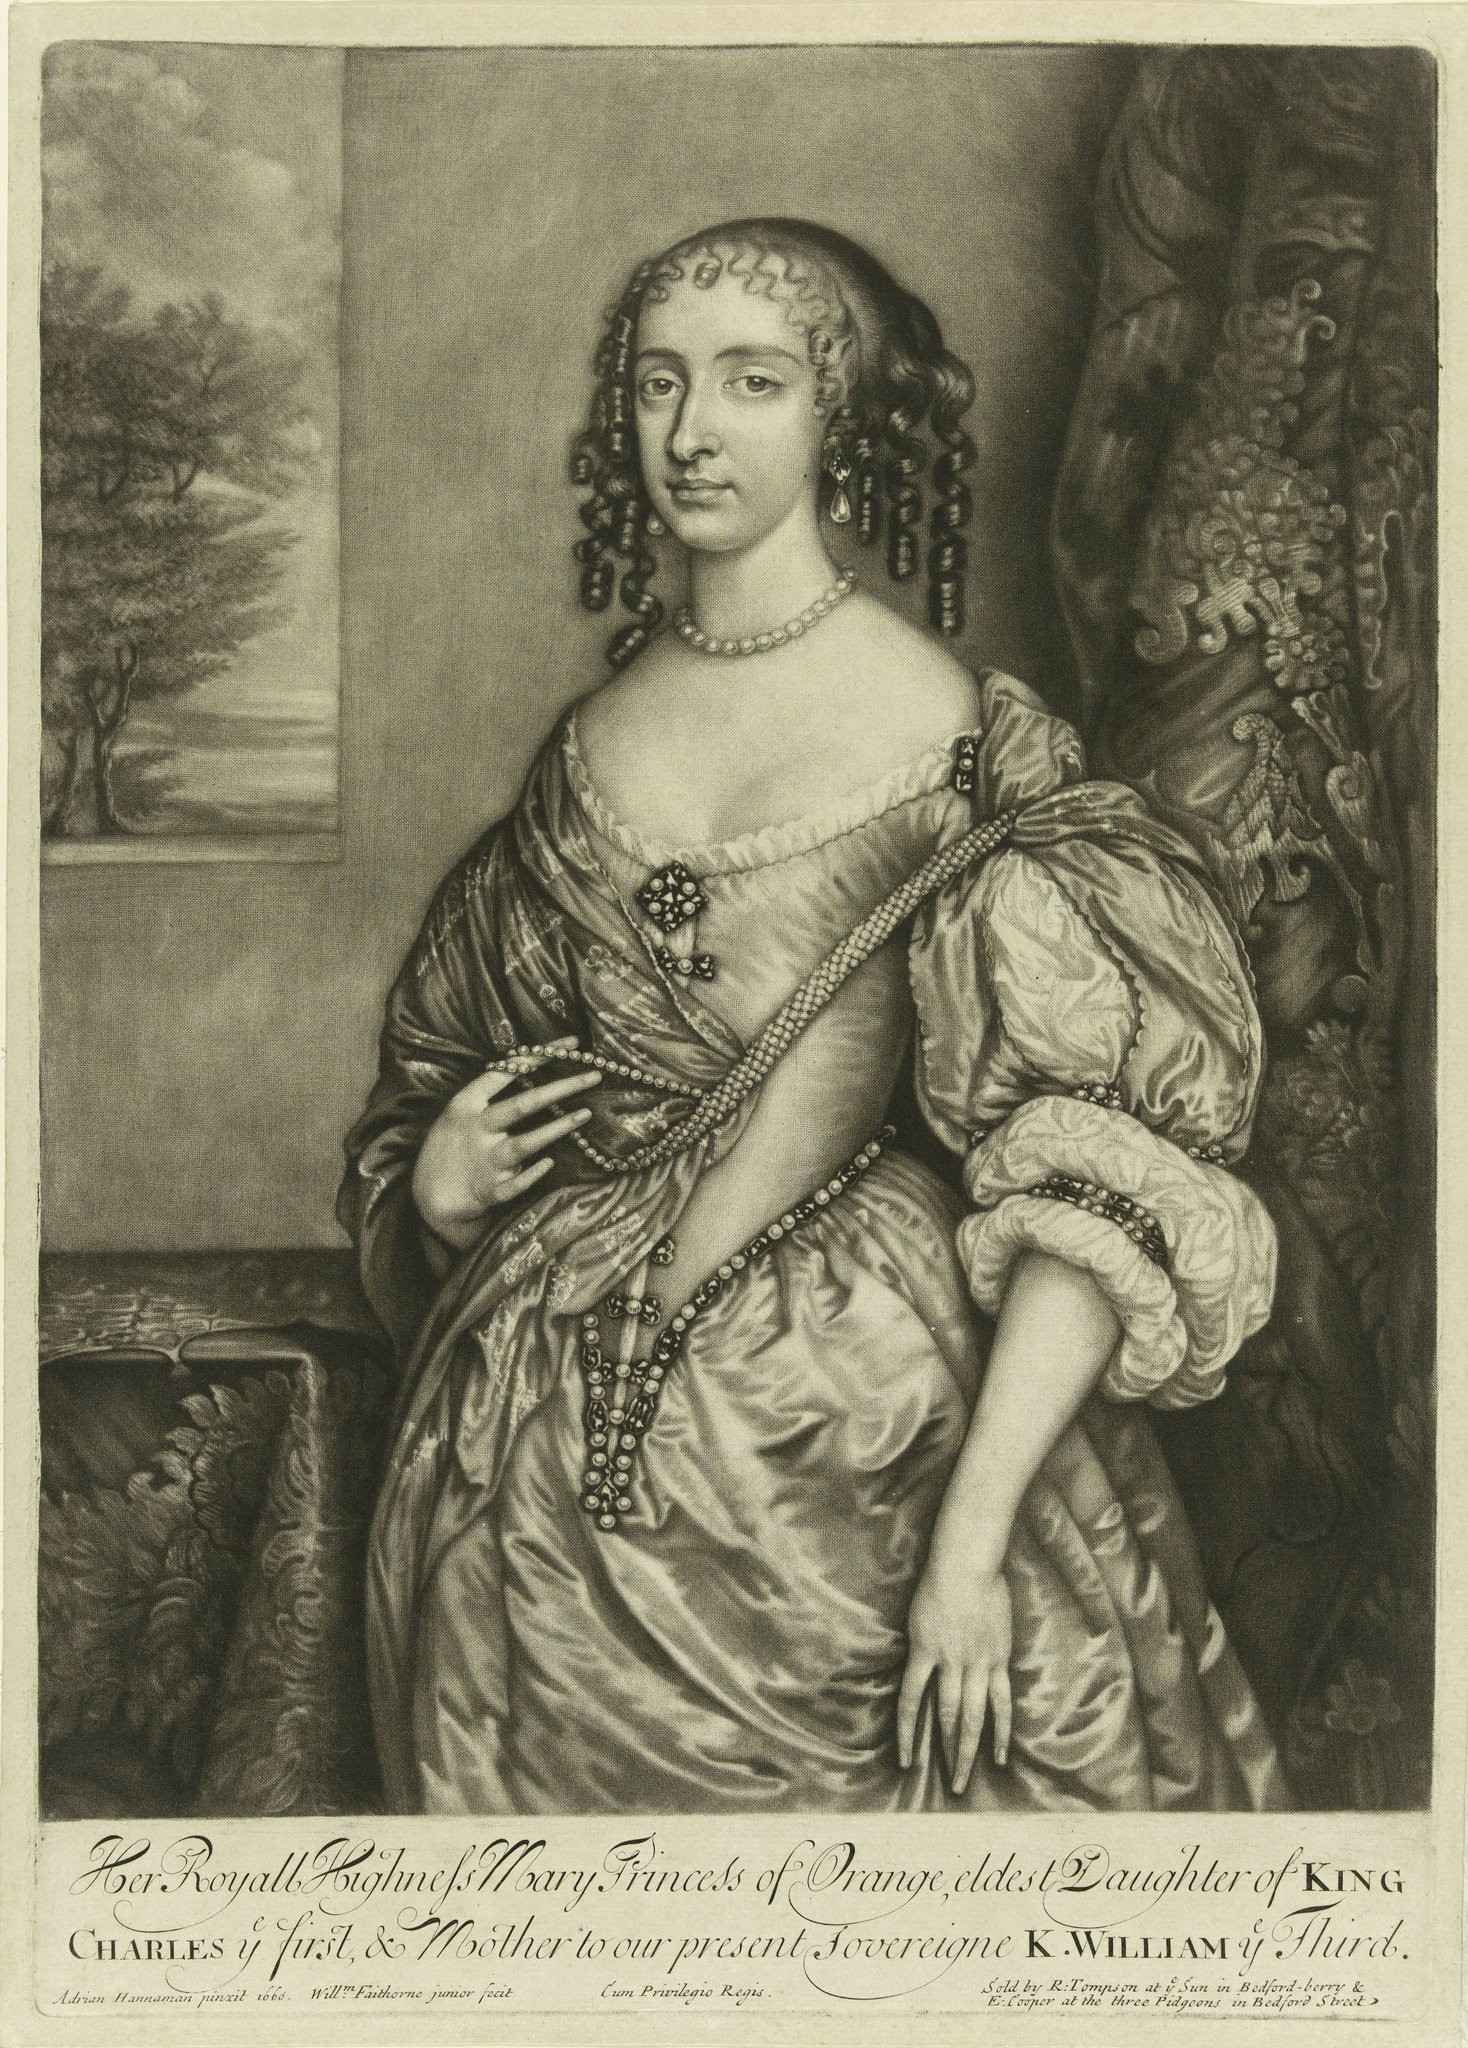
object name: print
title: Portret van Maria Henrietta Stuart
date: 1682-1725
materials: paper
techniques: mezzotint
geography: london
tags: london, mary henrietta stuart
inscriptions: collector's mark: Lugt 963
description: Portret van Maria Henrietta. Met haar rechterhand houdt ze haar ketting vast. In de ondermarge twee regels Engelse tekst.